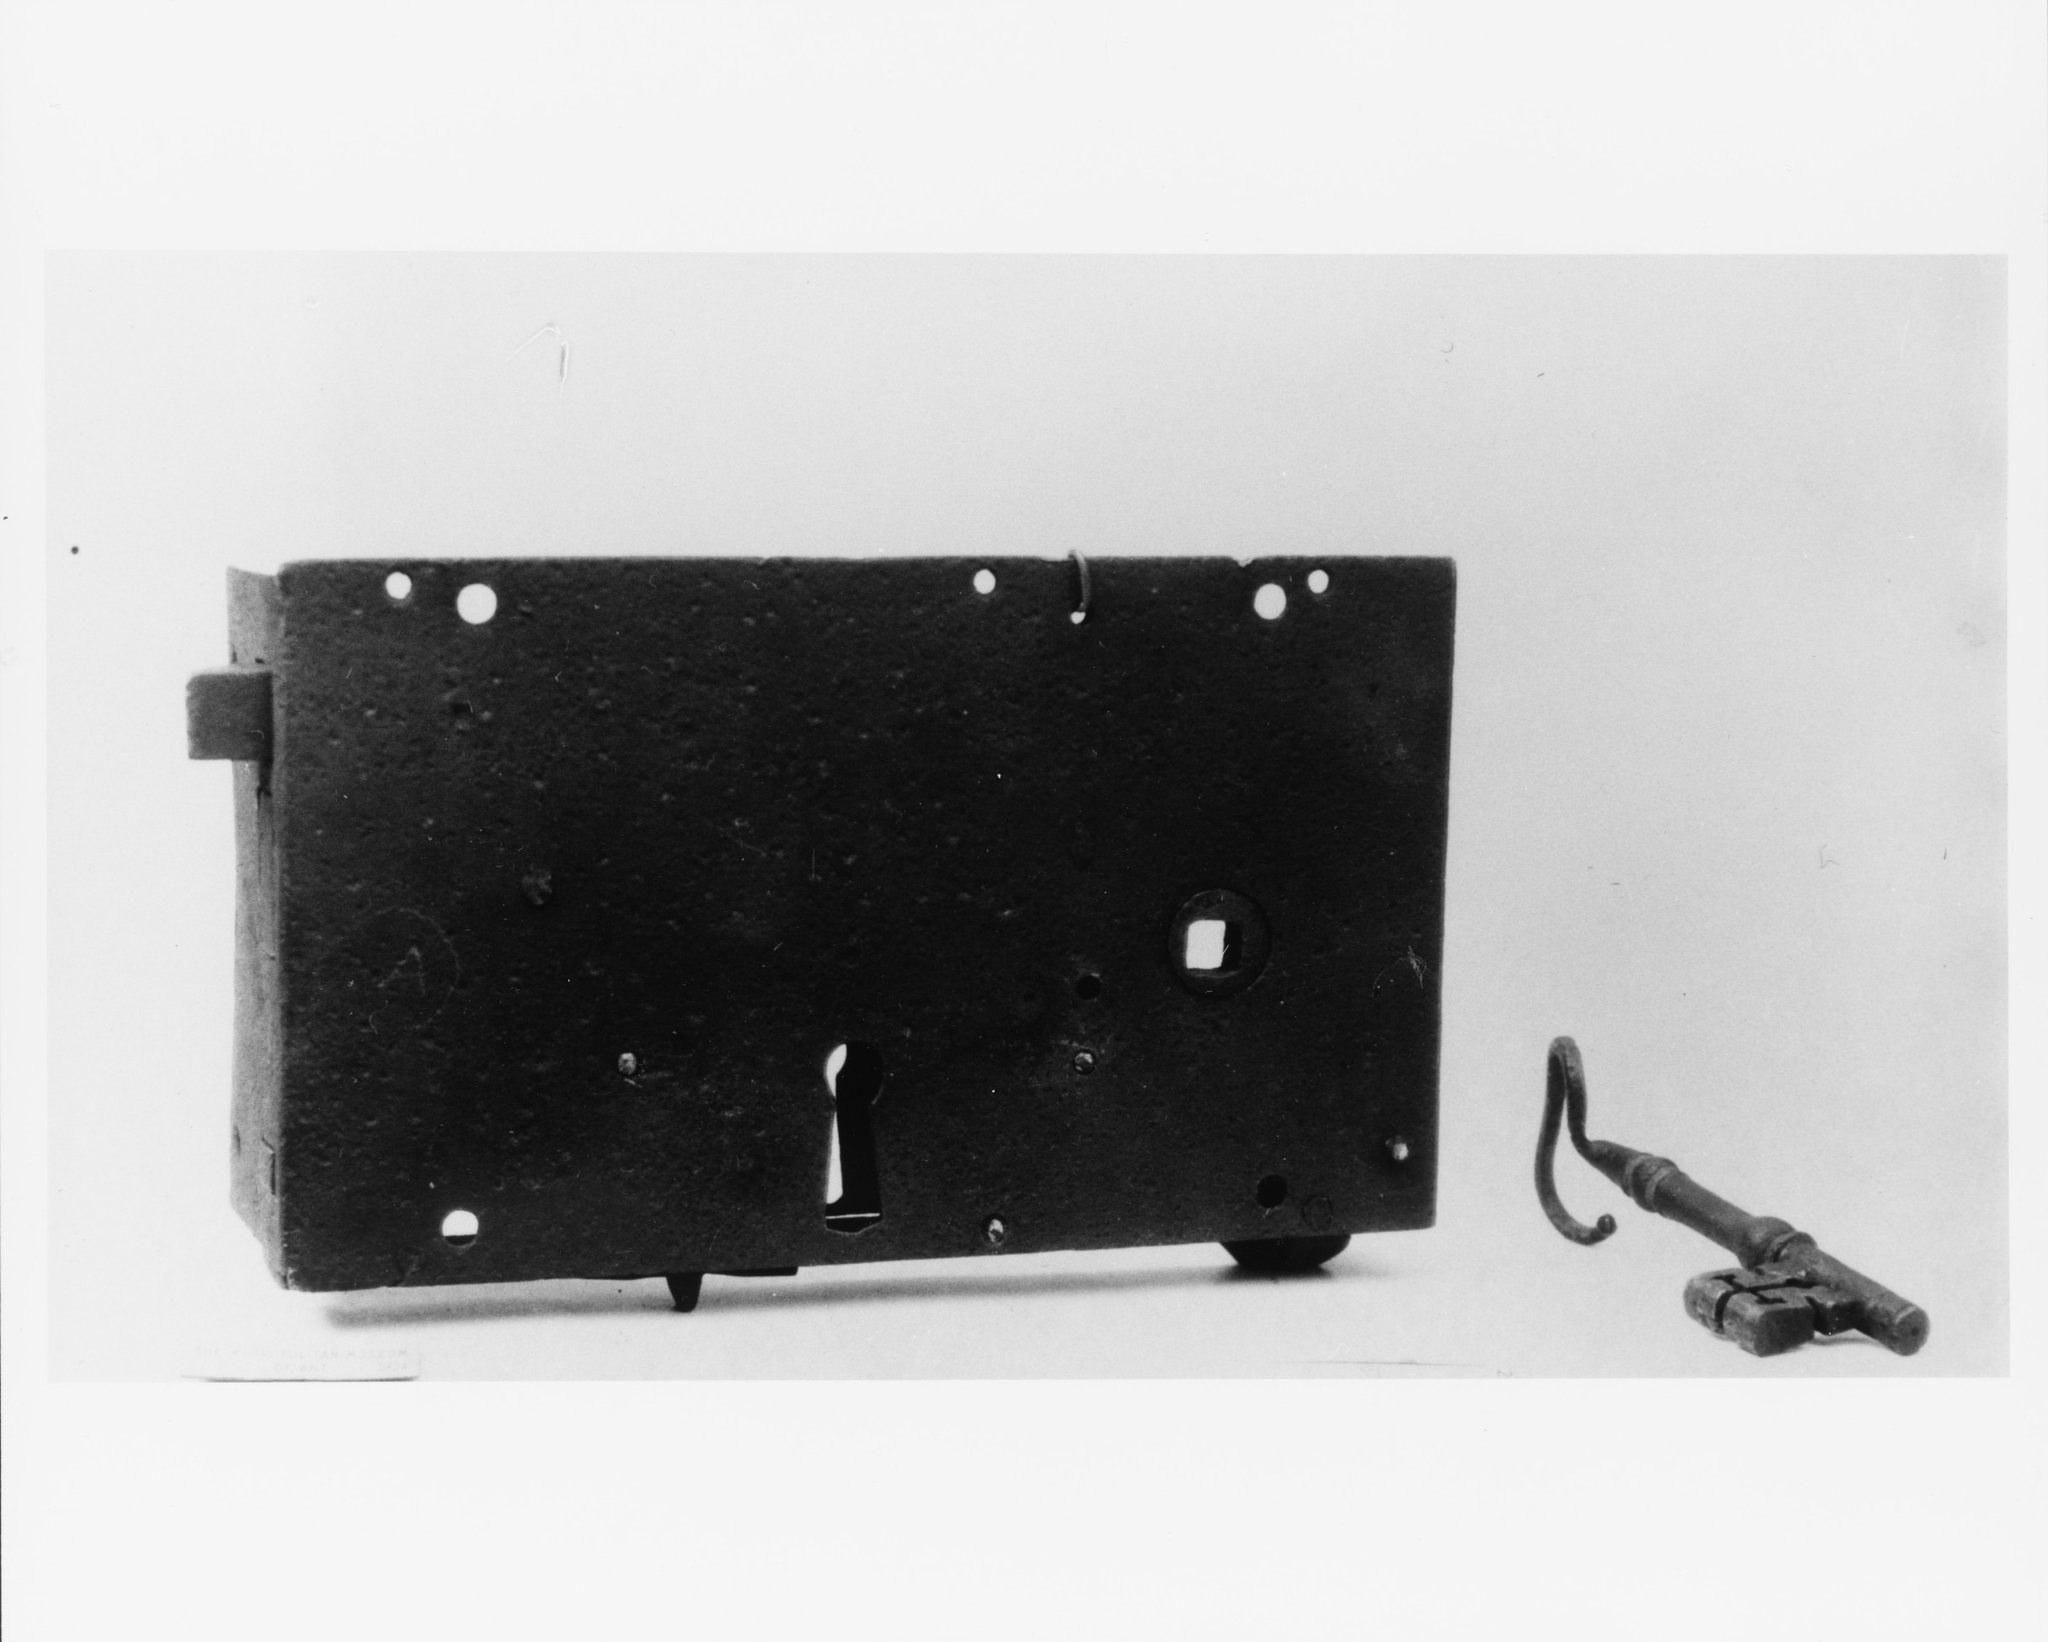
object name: lock and key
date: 1725-1750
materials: iron, wood